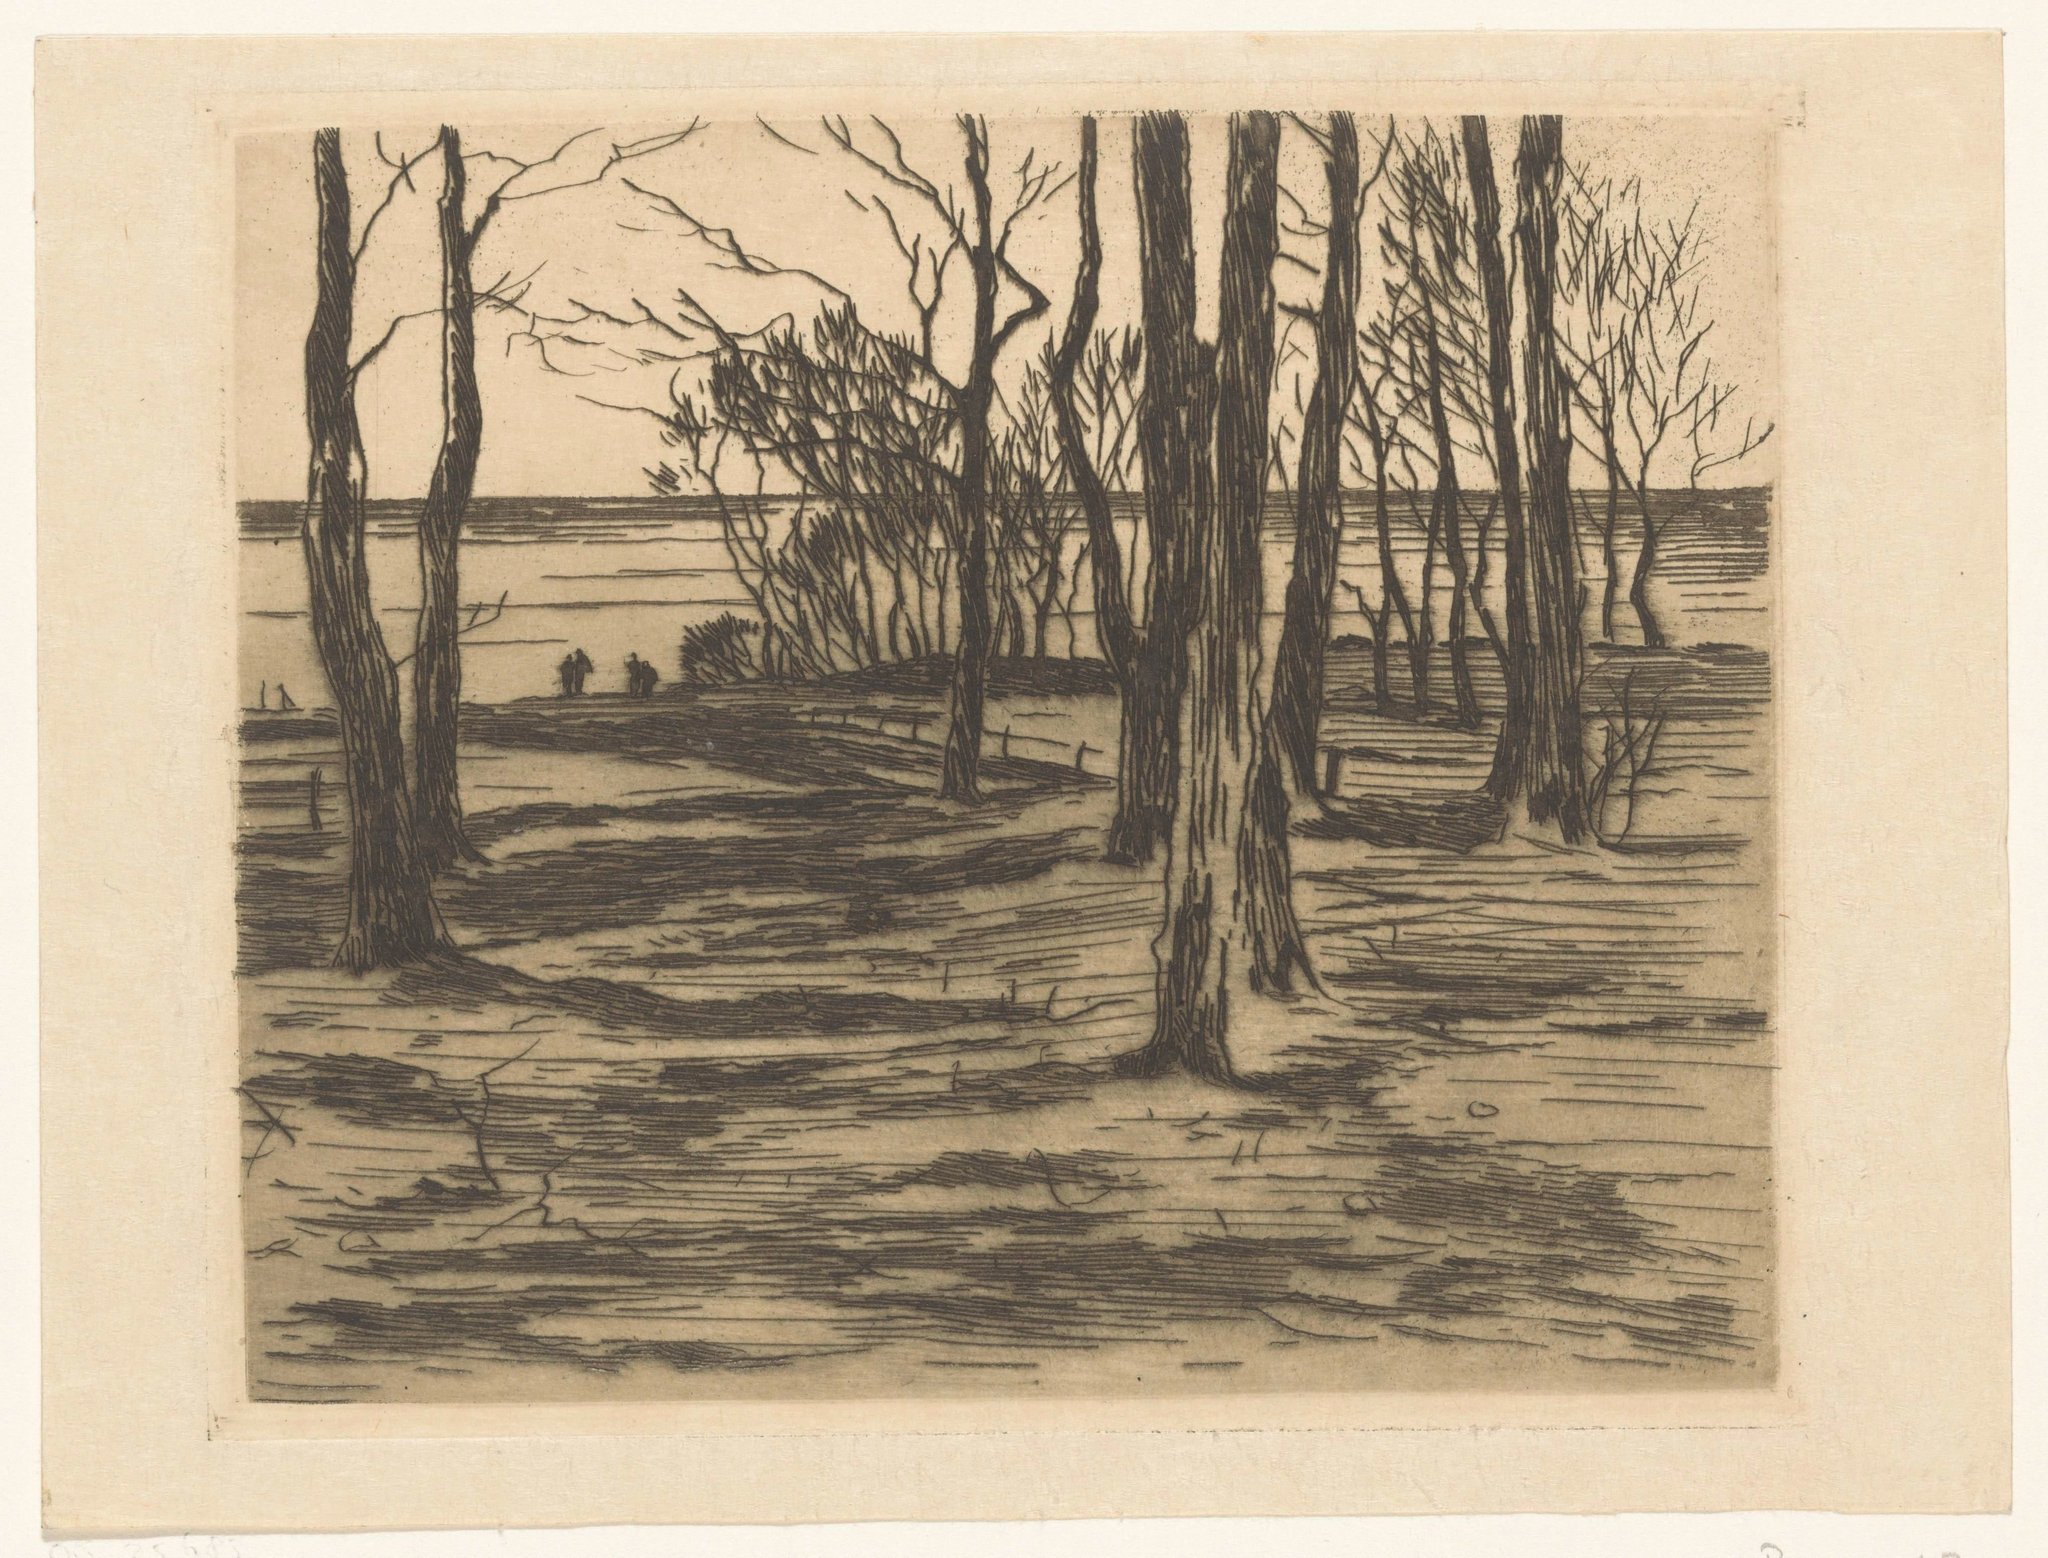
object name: print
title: Bomen aan de waterkant in Valkeveen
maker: willem witsen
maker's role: draughtsman, painter, print maker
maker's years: 1860-1923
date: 1913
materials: paper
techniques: etching, intaglio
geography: amsterdam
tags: trees, landscapes with waters, waterscapes, seascapes (in the temperate zone)